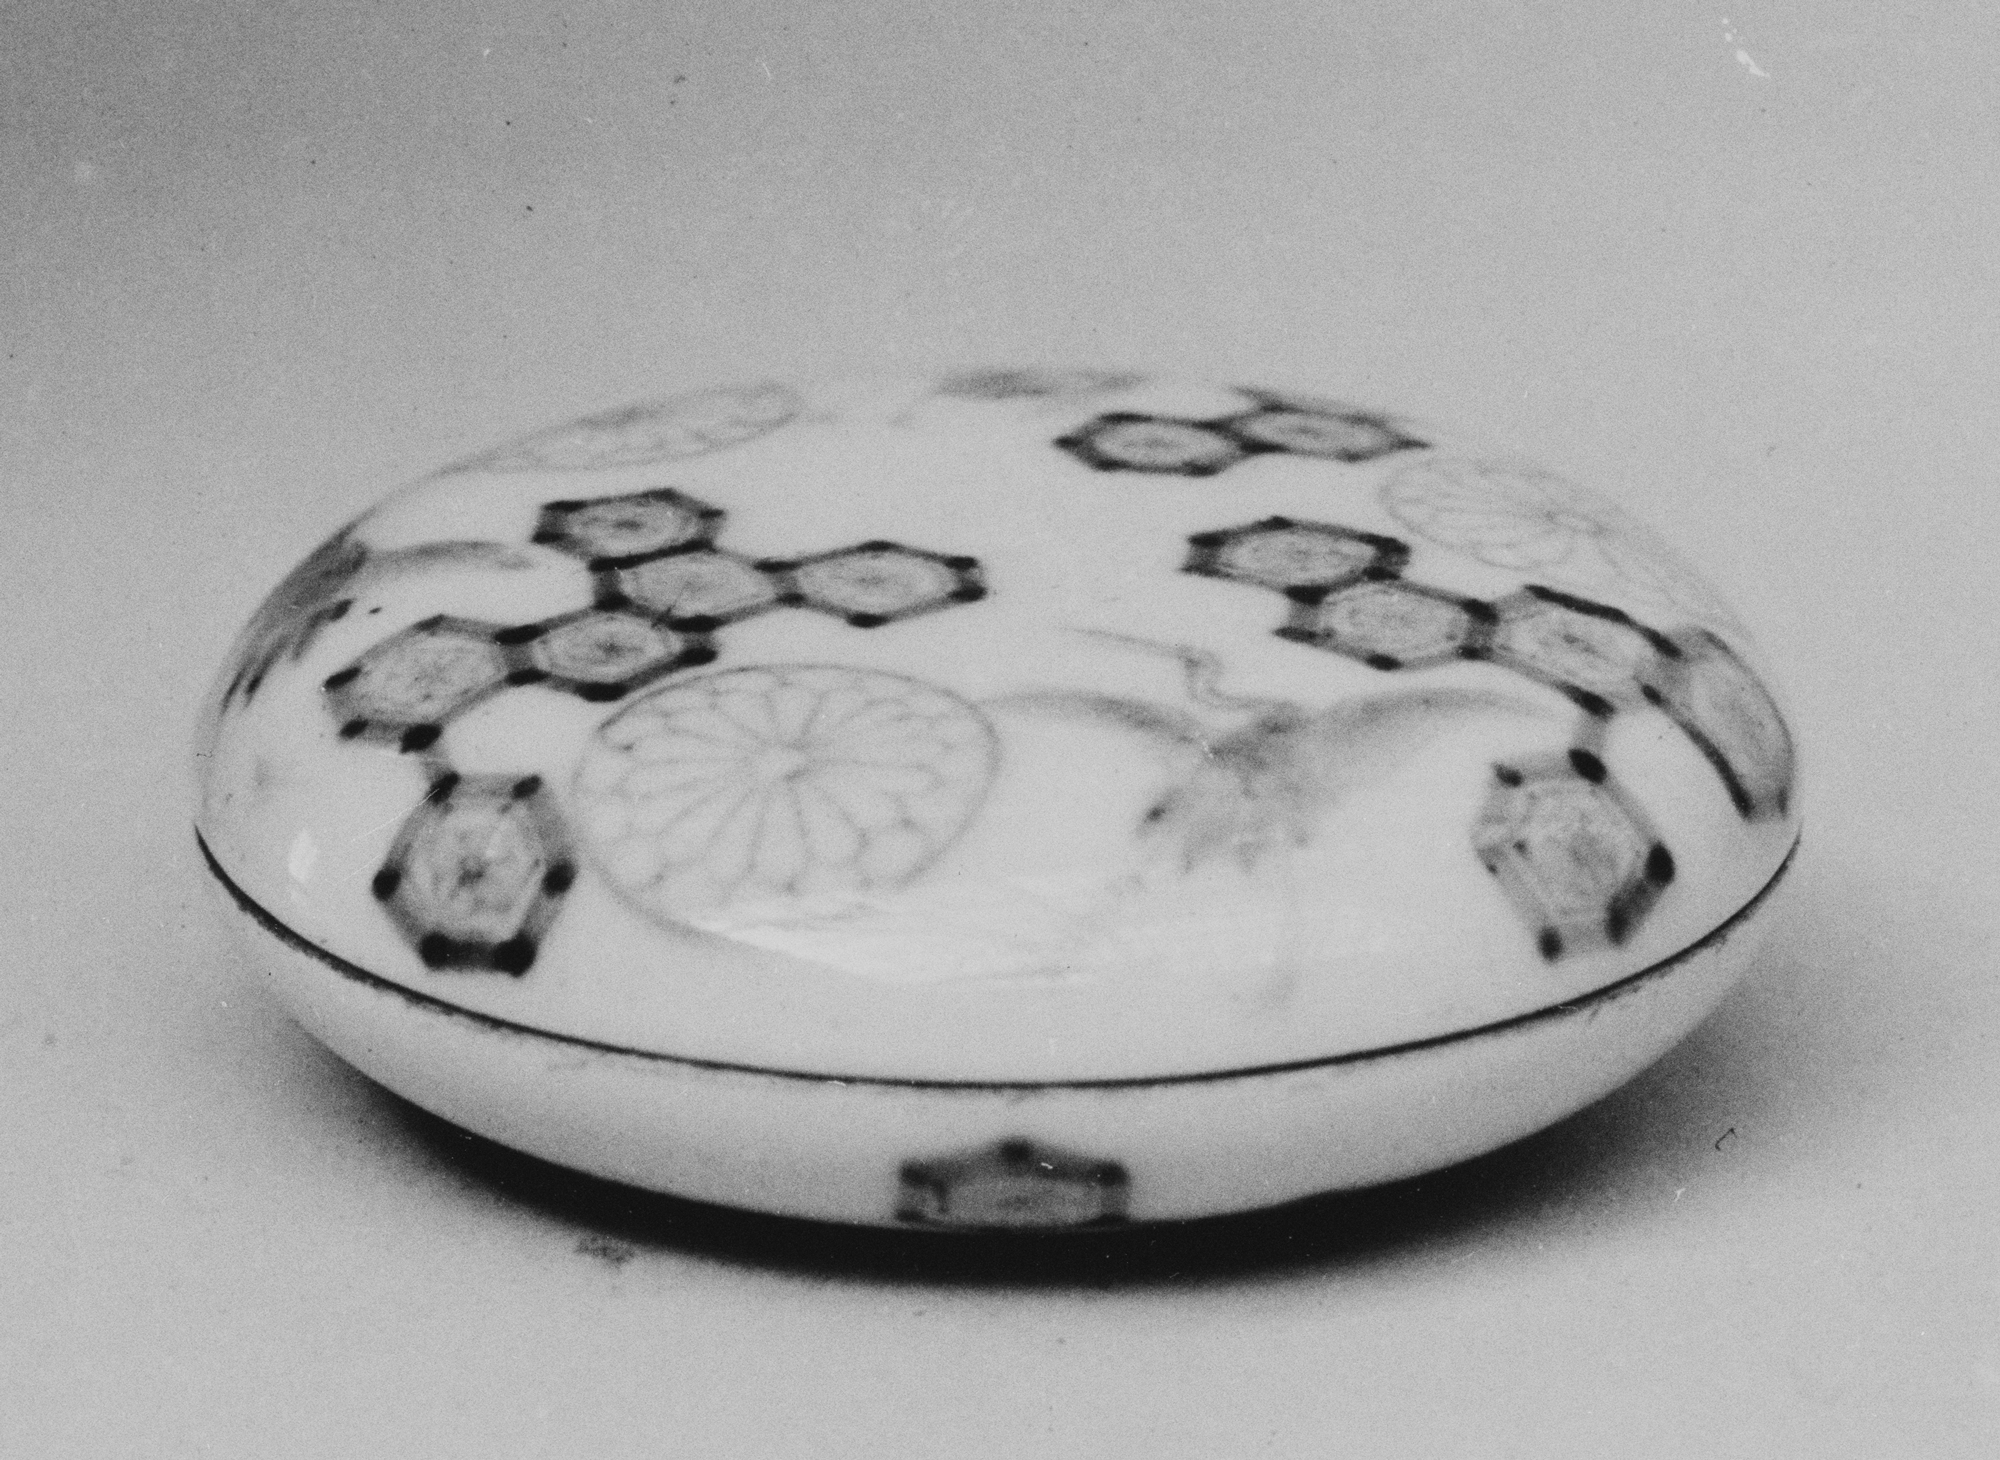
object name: box with cover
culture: japanese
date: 1820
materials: glaze, porcelain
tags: cranes